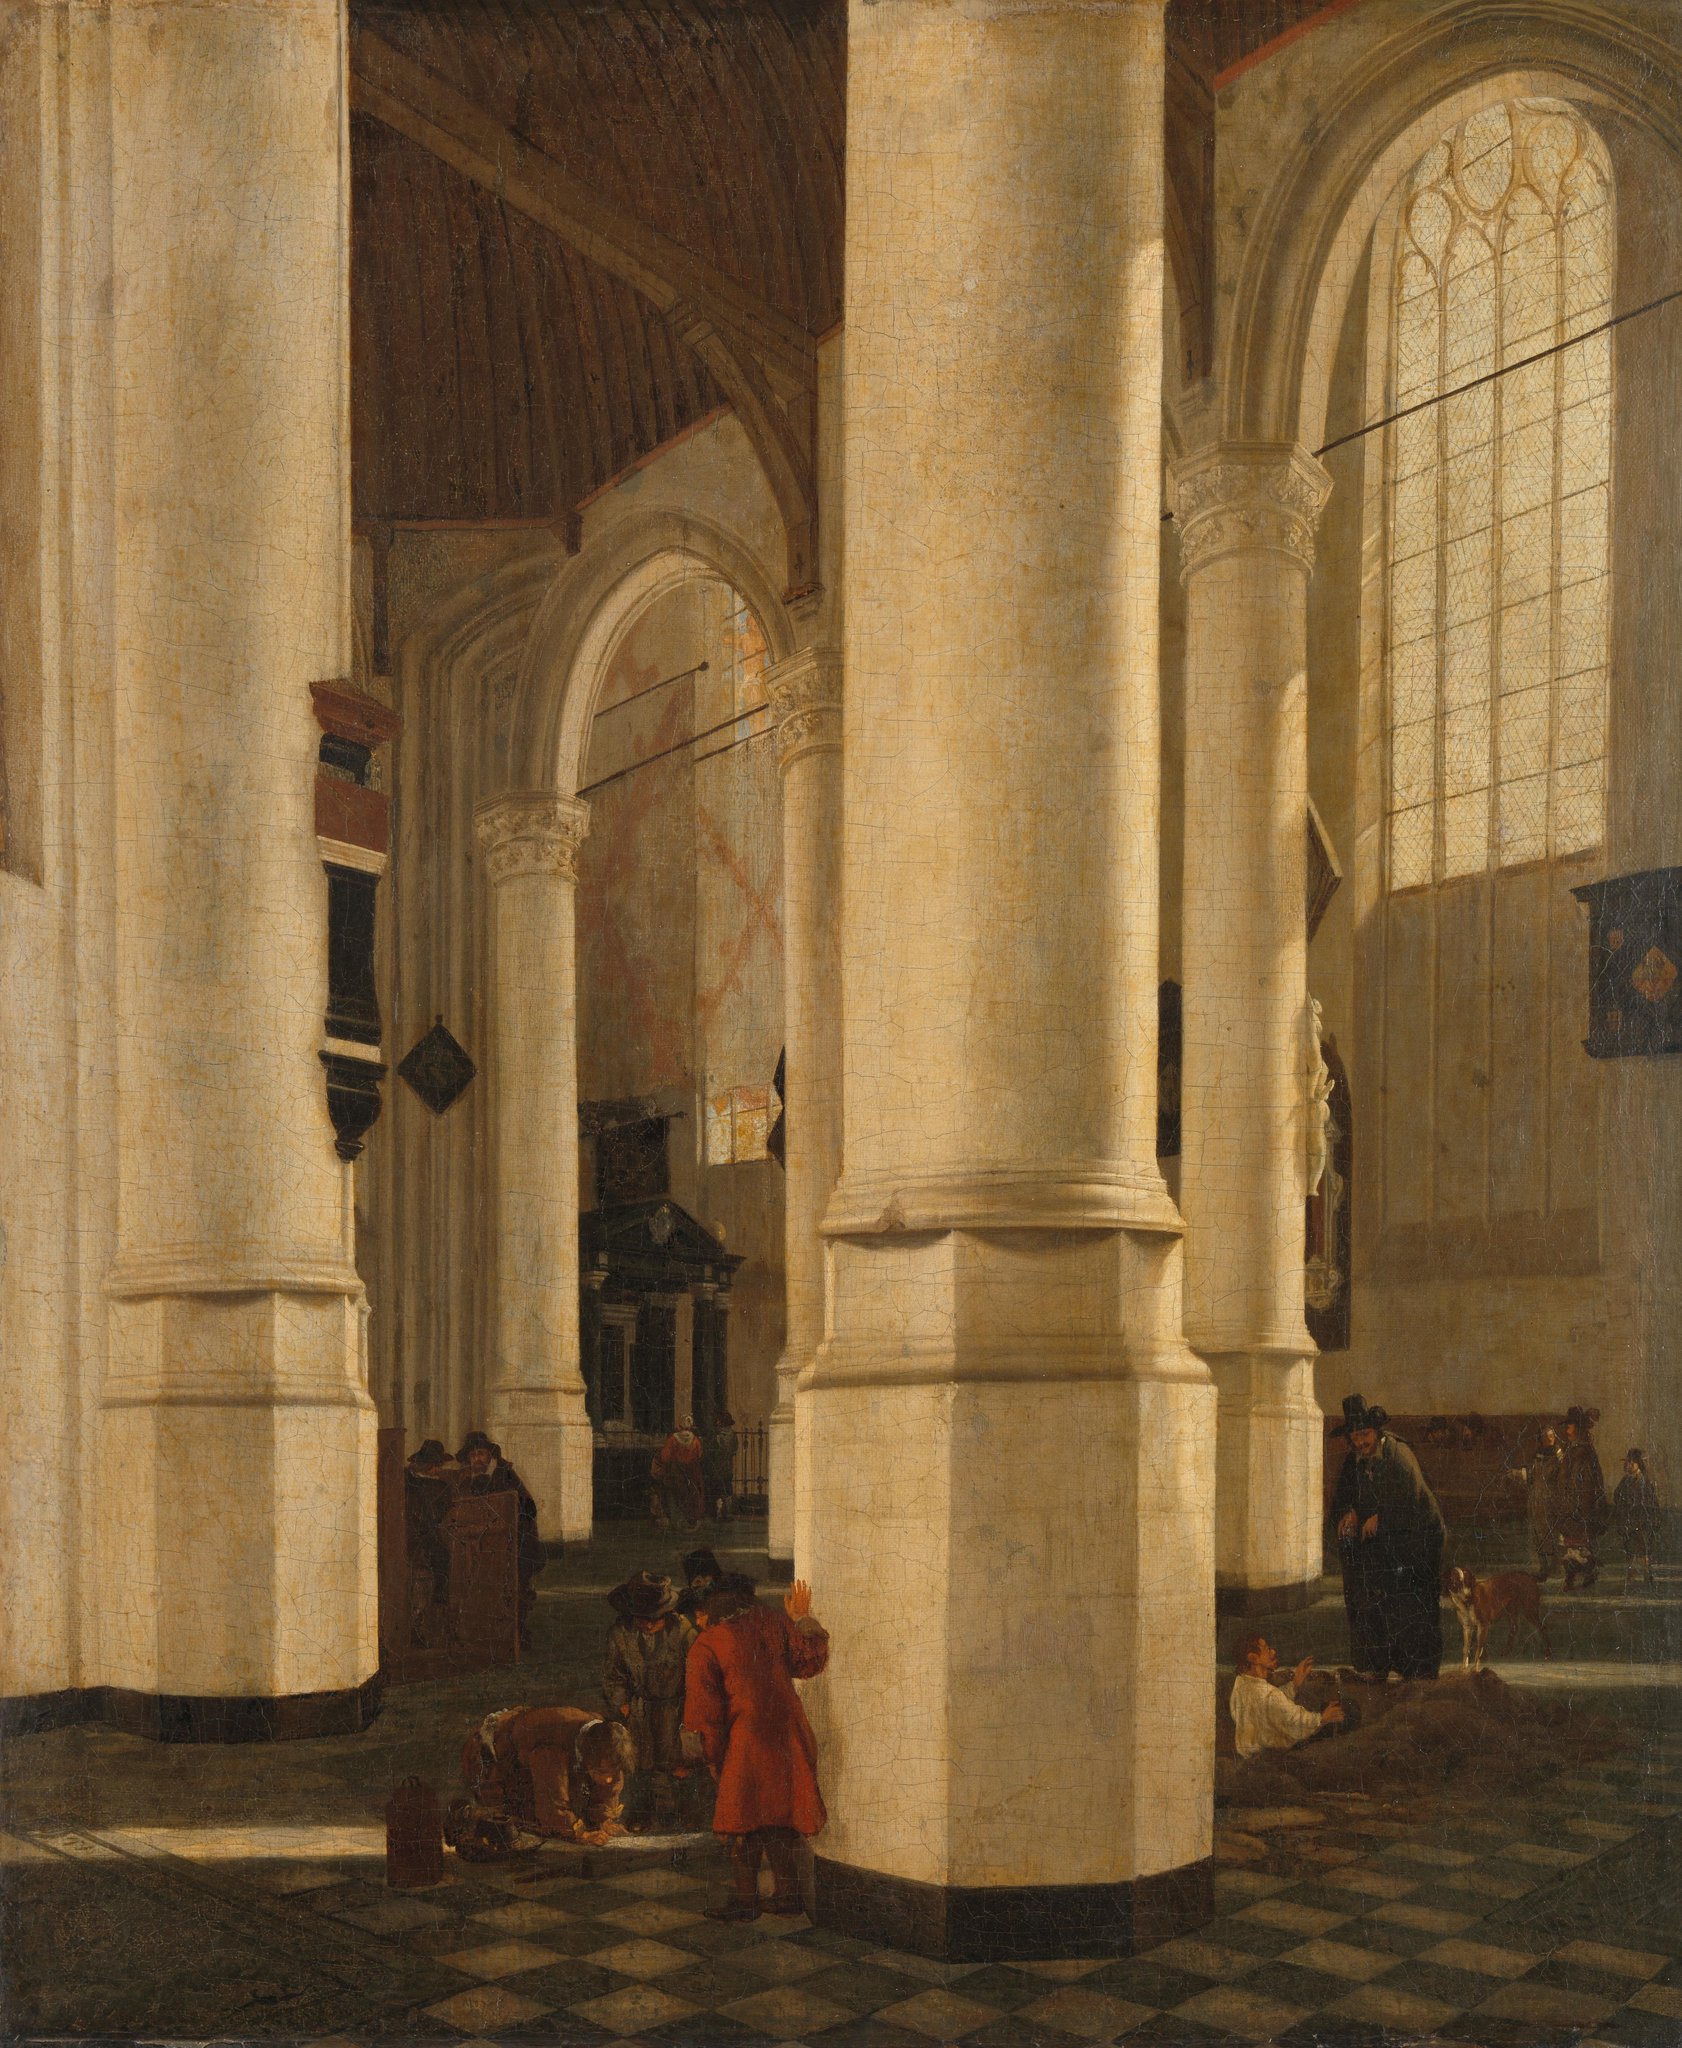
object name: painting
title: Interior of the Oude Kerk in Delft, with the Tomb of Vice-Admiral Piet Hein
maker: gerard houckgeest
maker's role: painter, print maker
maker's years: 1600-1661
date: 1650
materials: canvas, oil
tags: delfshaven, church (exterior), grave-building, monumental tomb, grave digger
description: Interieur van de Oude Kerk te Delft met de graftombe van Piet Hein, luitenant-admiraal van Holland. Links een groepje van drie figuren bij een zuil, rechts wordt een graf gedolven.